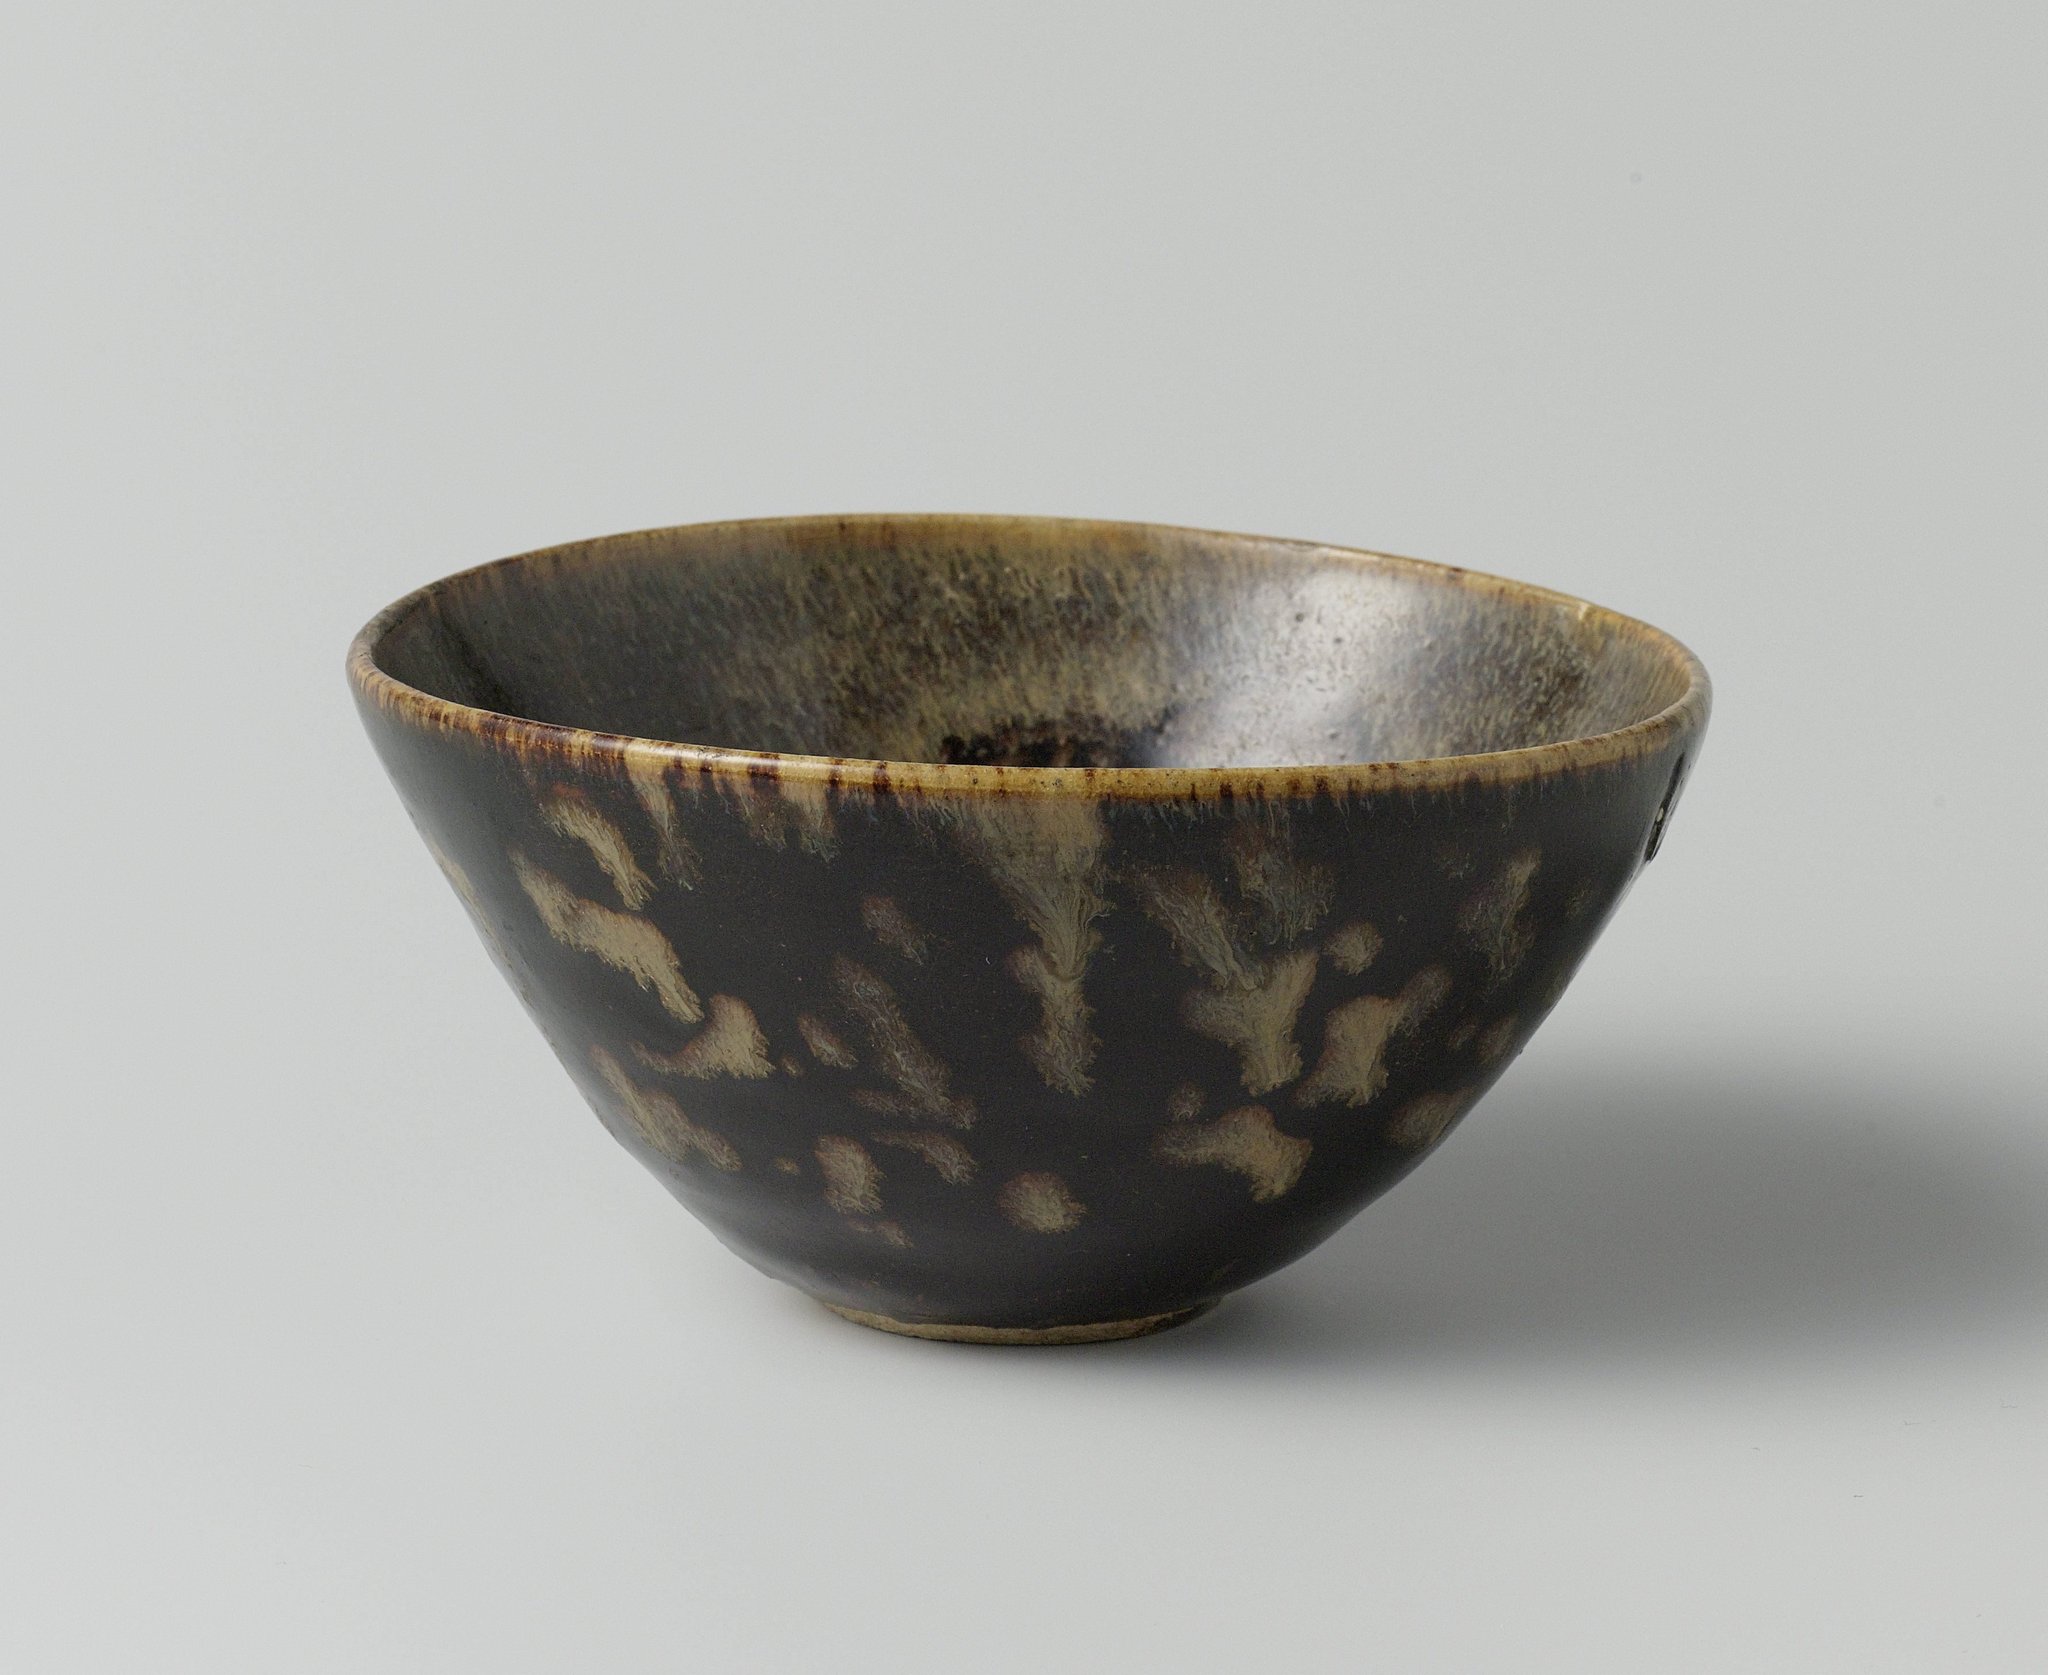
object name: bowl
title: Teabowl with three panels with characters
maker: Anonymous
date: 960-1279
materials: glaze, stoneware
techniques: firing, turning, vitrification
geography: china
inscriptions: inscription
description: Jizhou-ware tea bowls. China, Song period (960 - 1279). Glazed stoneware, Jizhou ware. The decoration on the inside of these bowls was applied by placing pieces of paper on the wet glaze. When fired, the paper burned away, leaving a dark pattern on the clay. These decorations (calligraphic characters, or birds, such as the phoenix) signify good luck, wealth and prosperity. Westendorp bequest.